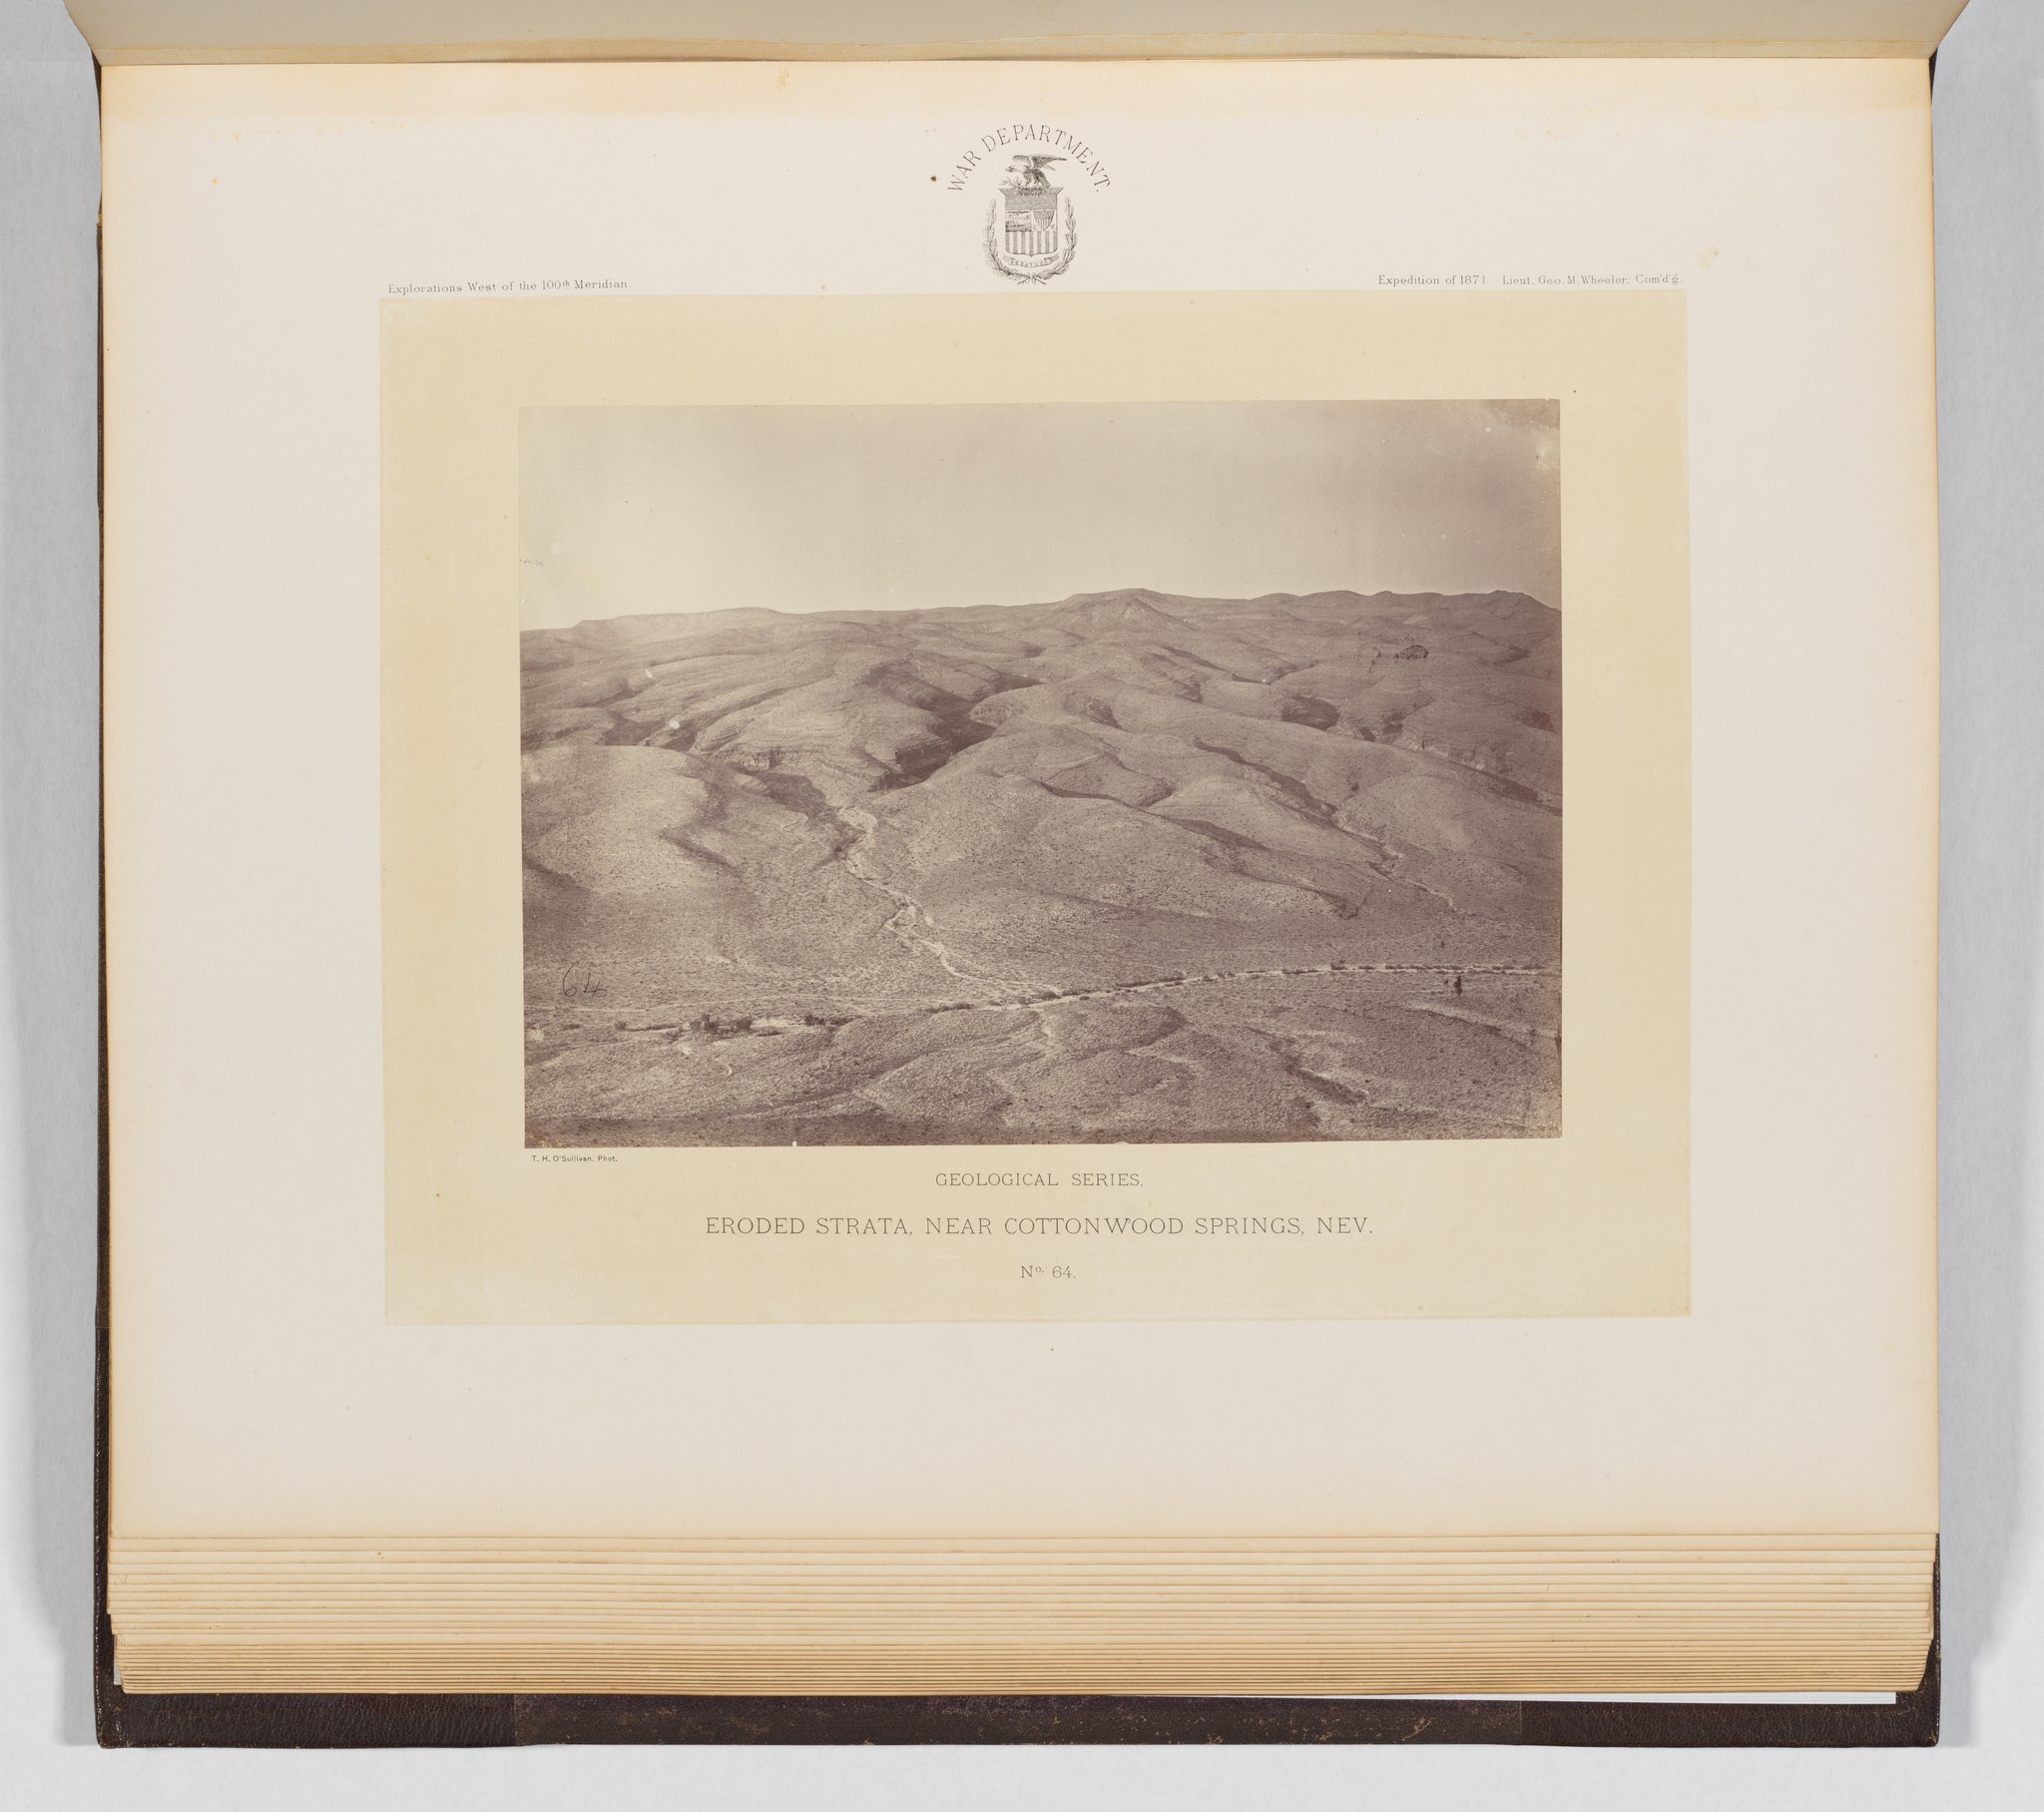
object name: photograph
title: Eroded Strata, Near Cottonwood Springs, Nevada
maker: timothy h. o'sullivan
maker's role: artist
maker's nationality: american, born ireland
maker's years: 1840-1882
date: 1871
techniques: albumen silver print, glass negative